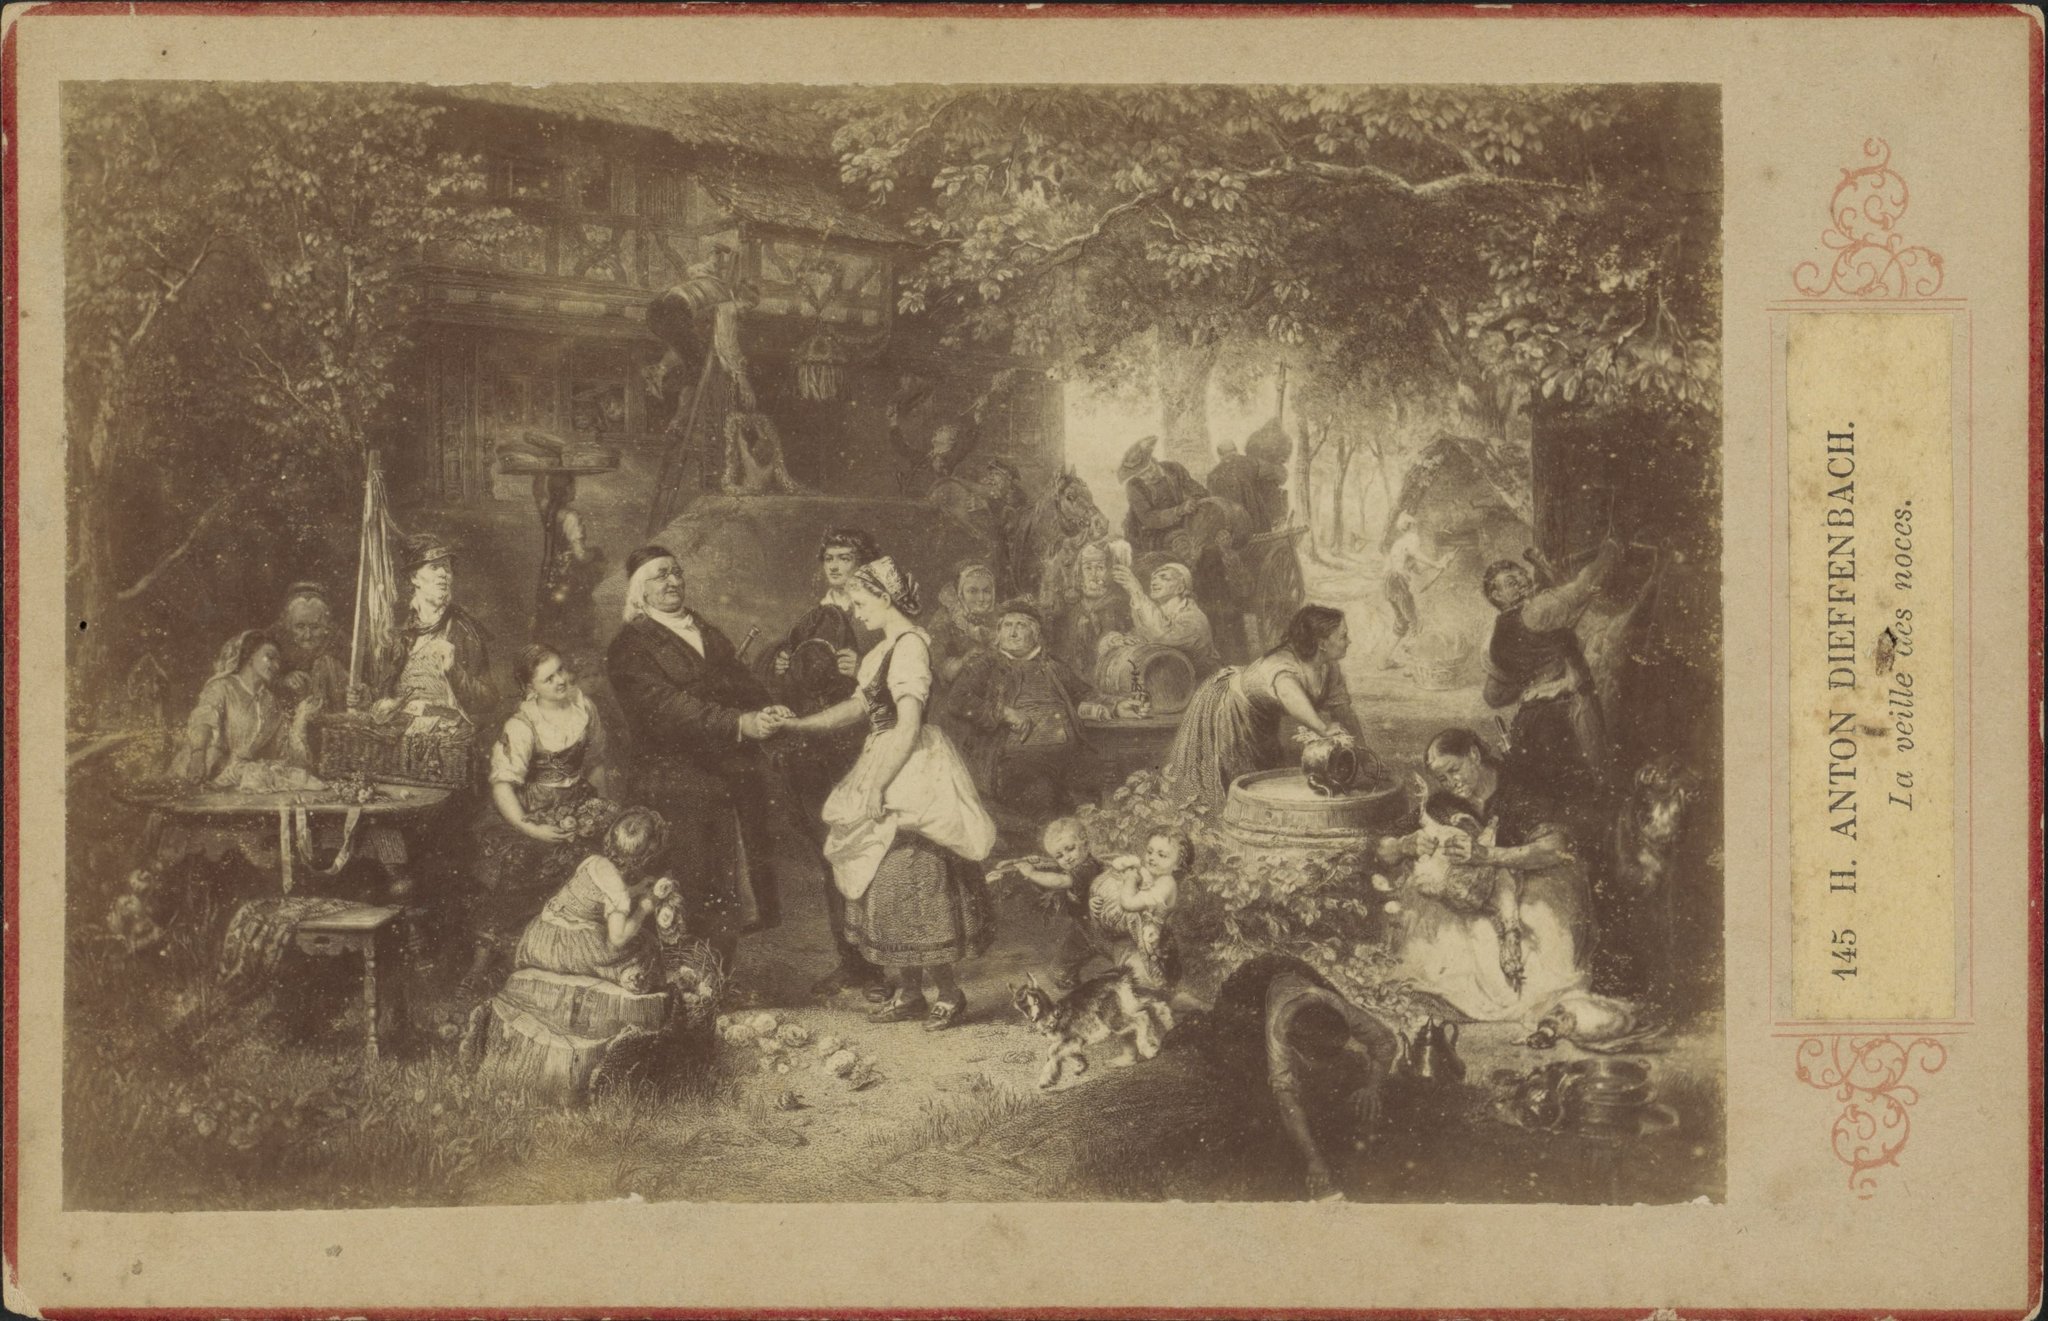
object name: cabinet photograph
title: La veille de noces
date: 1870-1890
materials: cardboard, paper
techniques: albumen print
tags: parental blessings and admonitions, village, (civil) marriage ceremonies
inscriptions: number: ‘50’, number: ‘145’